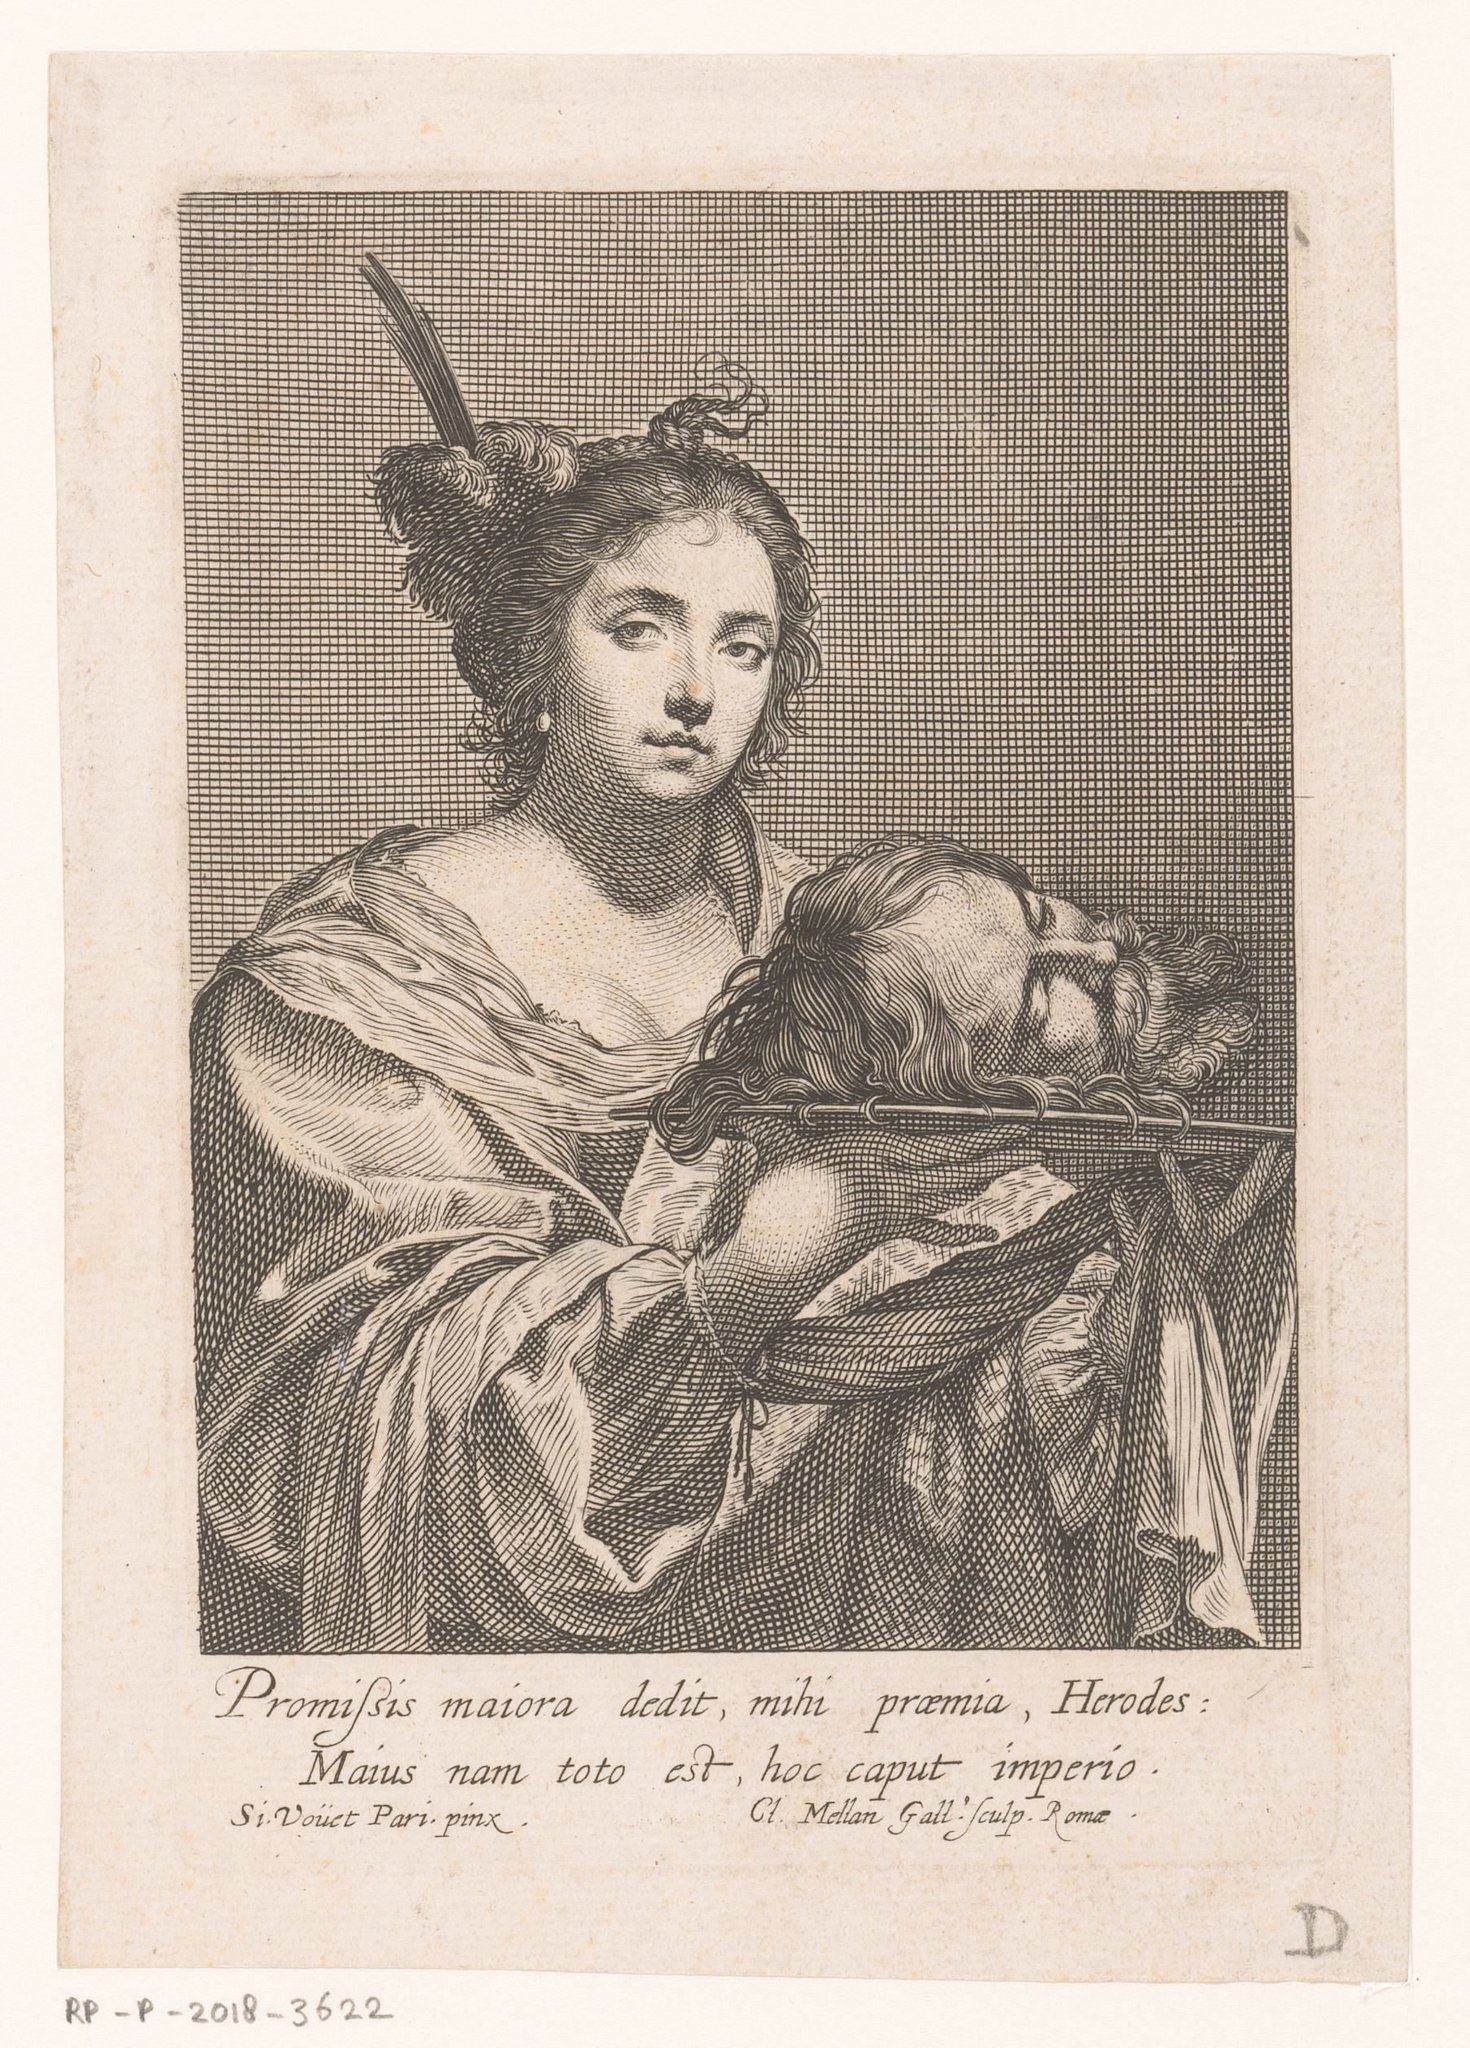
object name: print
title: Herodias met het hoofd van Johannes de Doper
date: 1608-1688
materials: paper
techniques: engraving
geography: paris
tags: the beheading of john the baptist